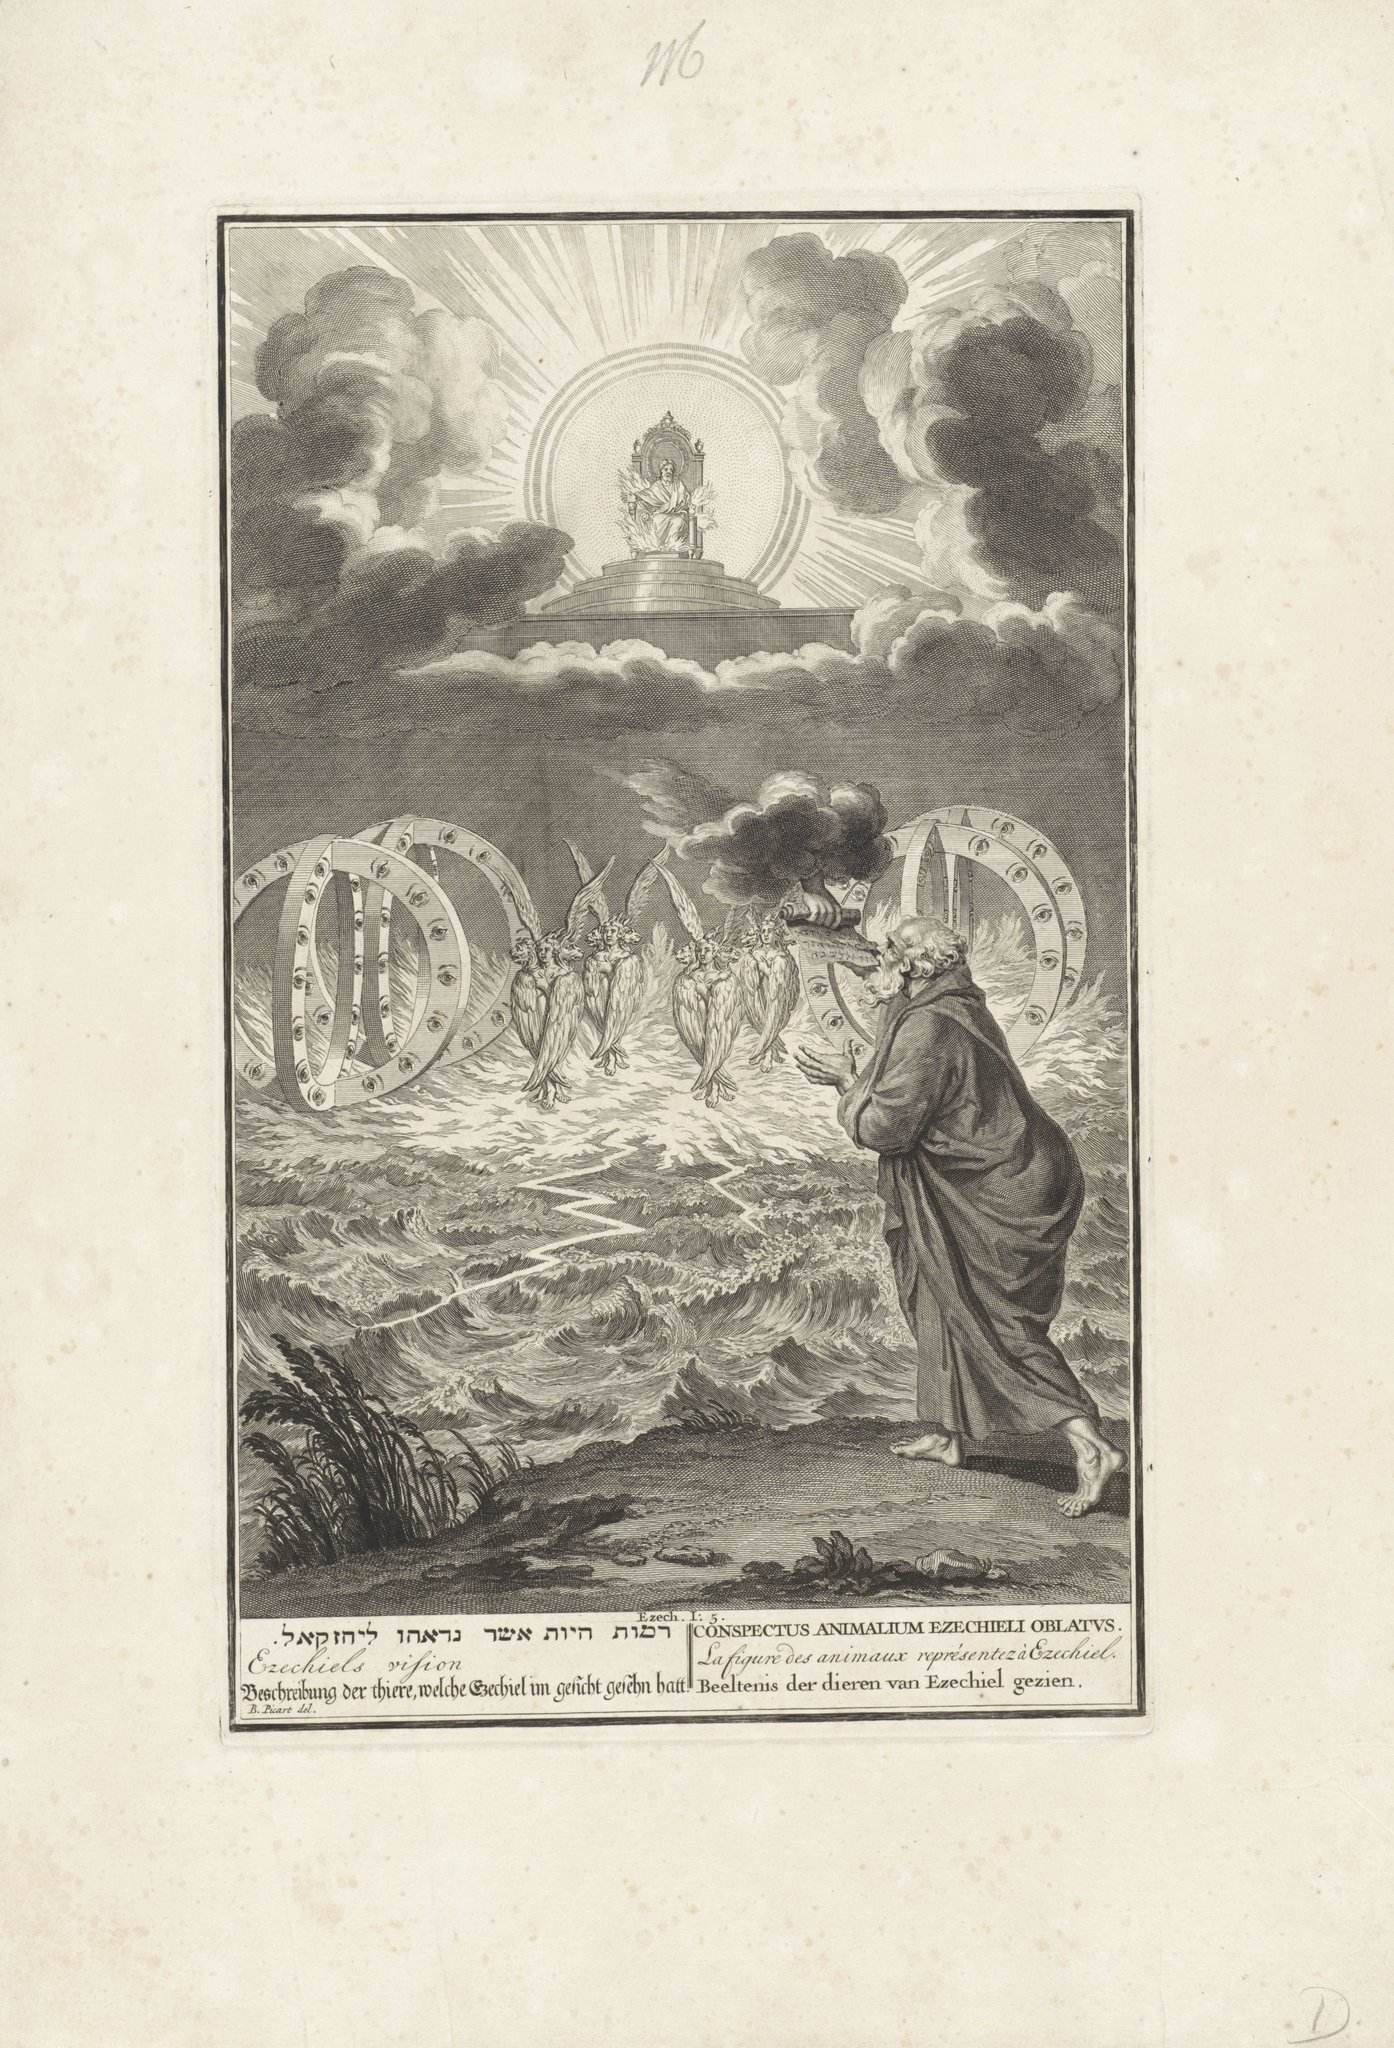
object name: print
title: Beeltenis der dieren van Ezechiel gezien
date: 1693-1783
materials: paper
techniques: etching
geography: low countries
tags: ezekiel's vision of god sitting on his throne carried by four tetramorphs, each of them having four wings; wheels within wheels beside them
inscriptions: collector's mark: Lugt 2228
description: Visioen van de profeet Ezechiël. God zit op zijn troon. Hij wordt door vlammen en lichtstralen omgeven. Op het water vier tetramorfe wezens, elk met vier gezichten - van een adelaar, een rund, een mens en een leeuw - en vier vleugels. Naast elk wezen een dubbel rad met ogen. Ezechiël staat rechts en ontvangt een boekrol met een Hebreeuwse tekst uit de hand van God. Onderaan een éénregelige titel in het Hebreeuws, Engels, Duits, Latijn, Frans en Nederlands uit Ez. 1:5.